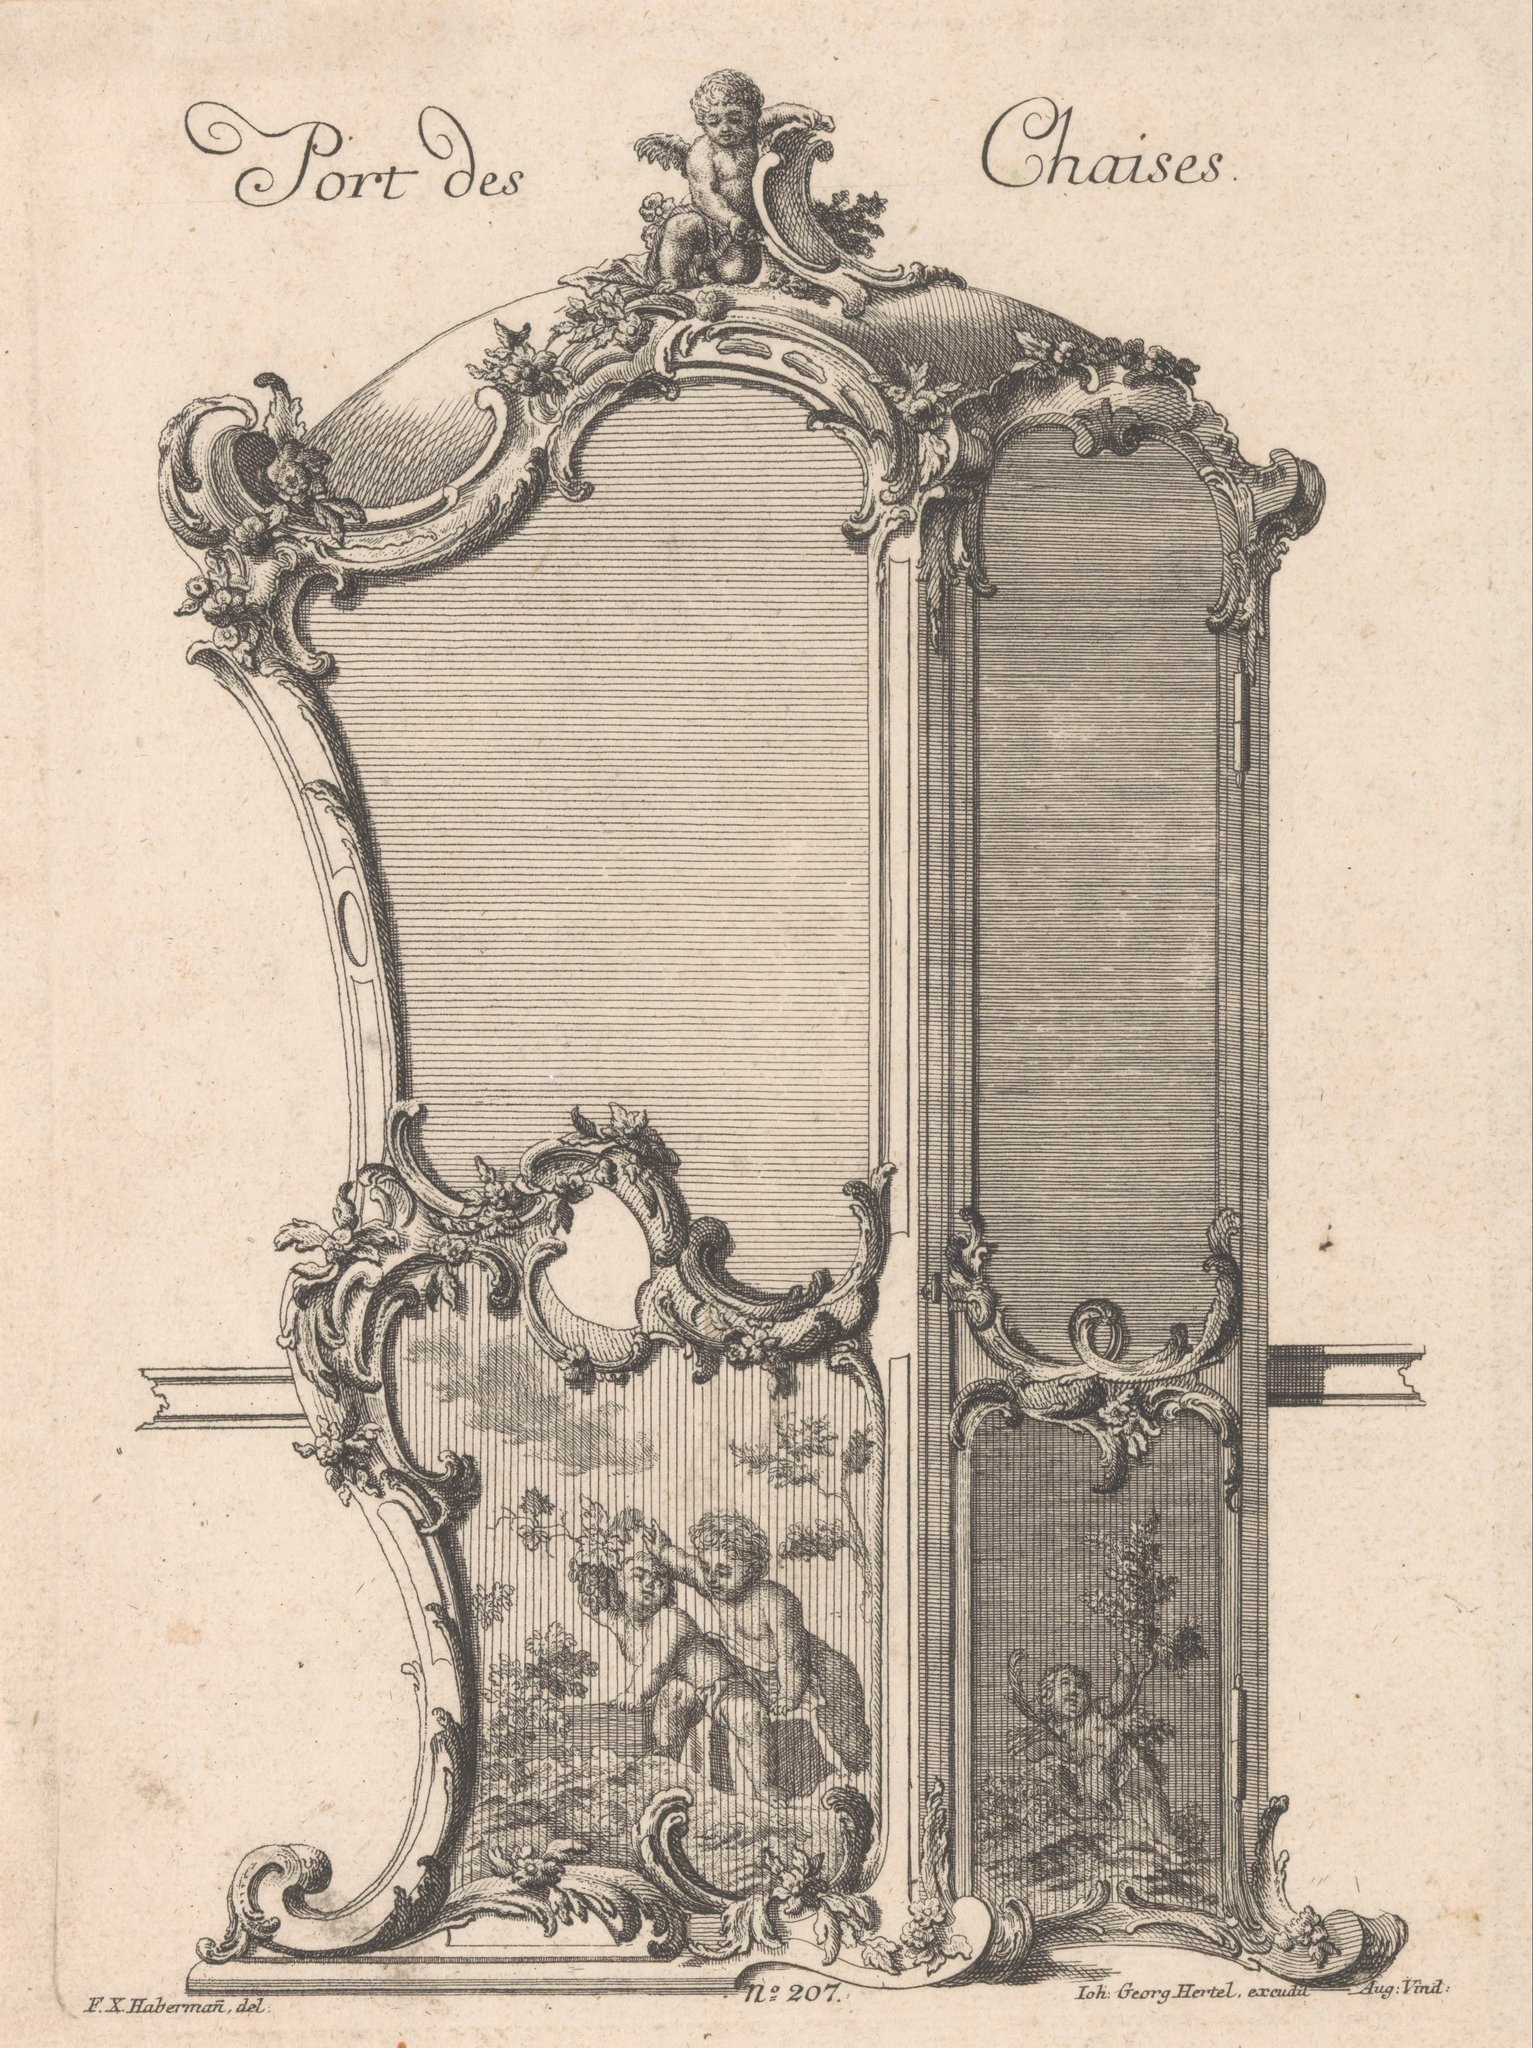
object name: titelprent, frontispice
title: Draagkoetsen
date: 1731-1775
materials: paper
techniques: engraving, etching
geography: augsburg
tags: (carrying a person in a) sedan-chair, cupids: 'amores', 'amoretti', 'putti'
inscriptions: collector's mark: Lugt 2228, collector's mark: Lugt 2760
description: Draagkoets met rocaille ornamenten, bloemmotieven, een gevleugelde putto boven en beschilderingen met drie putti. Uitgeversnummer 207.